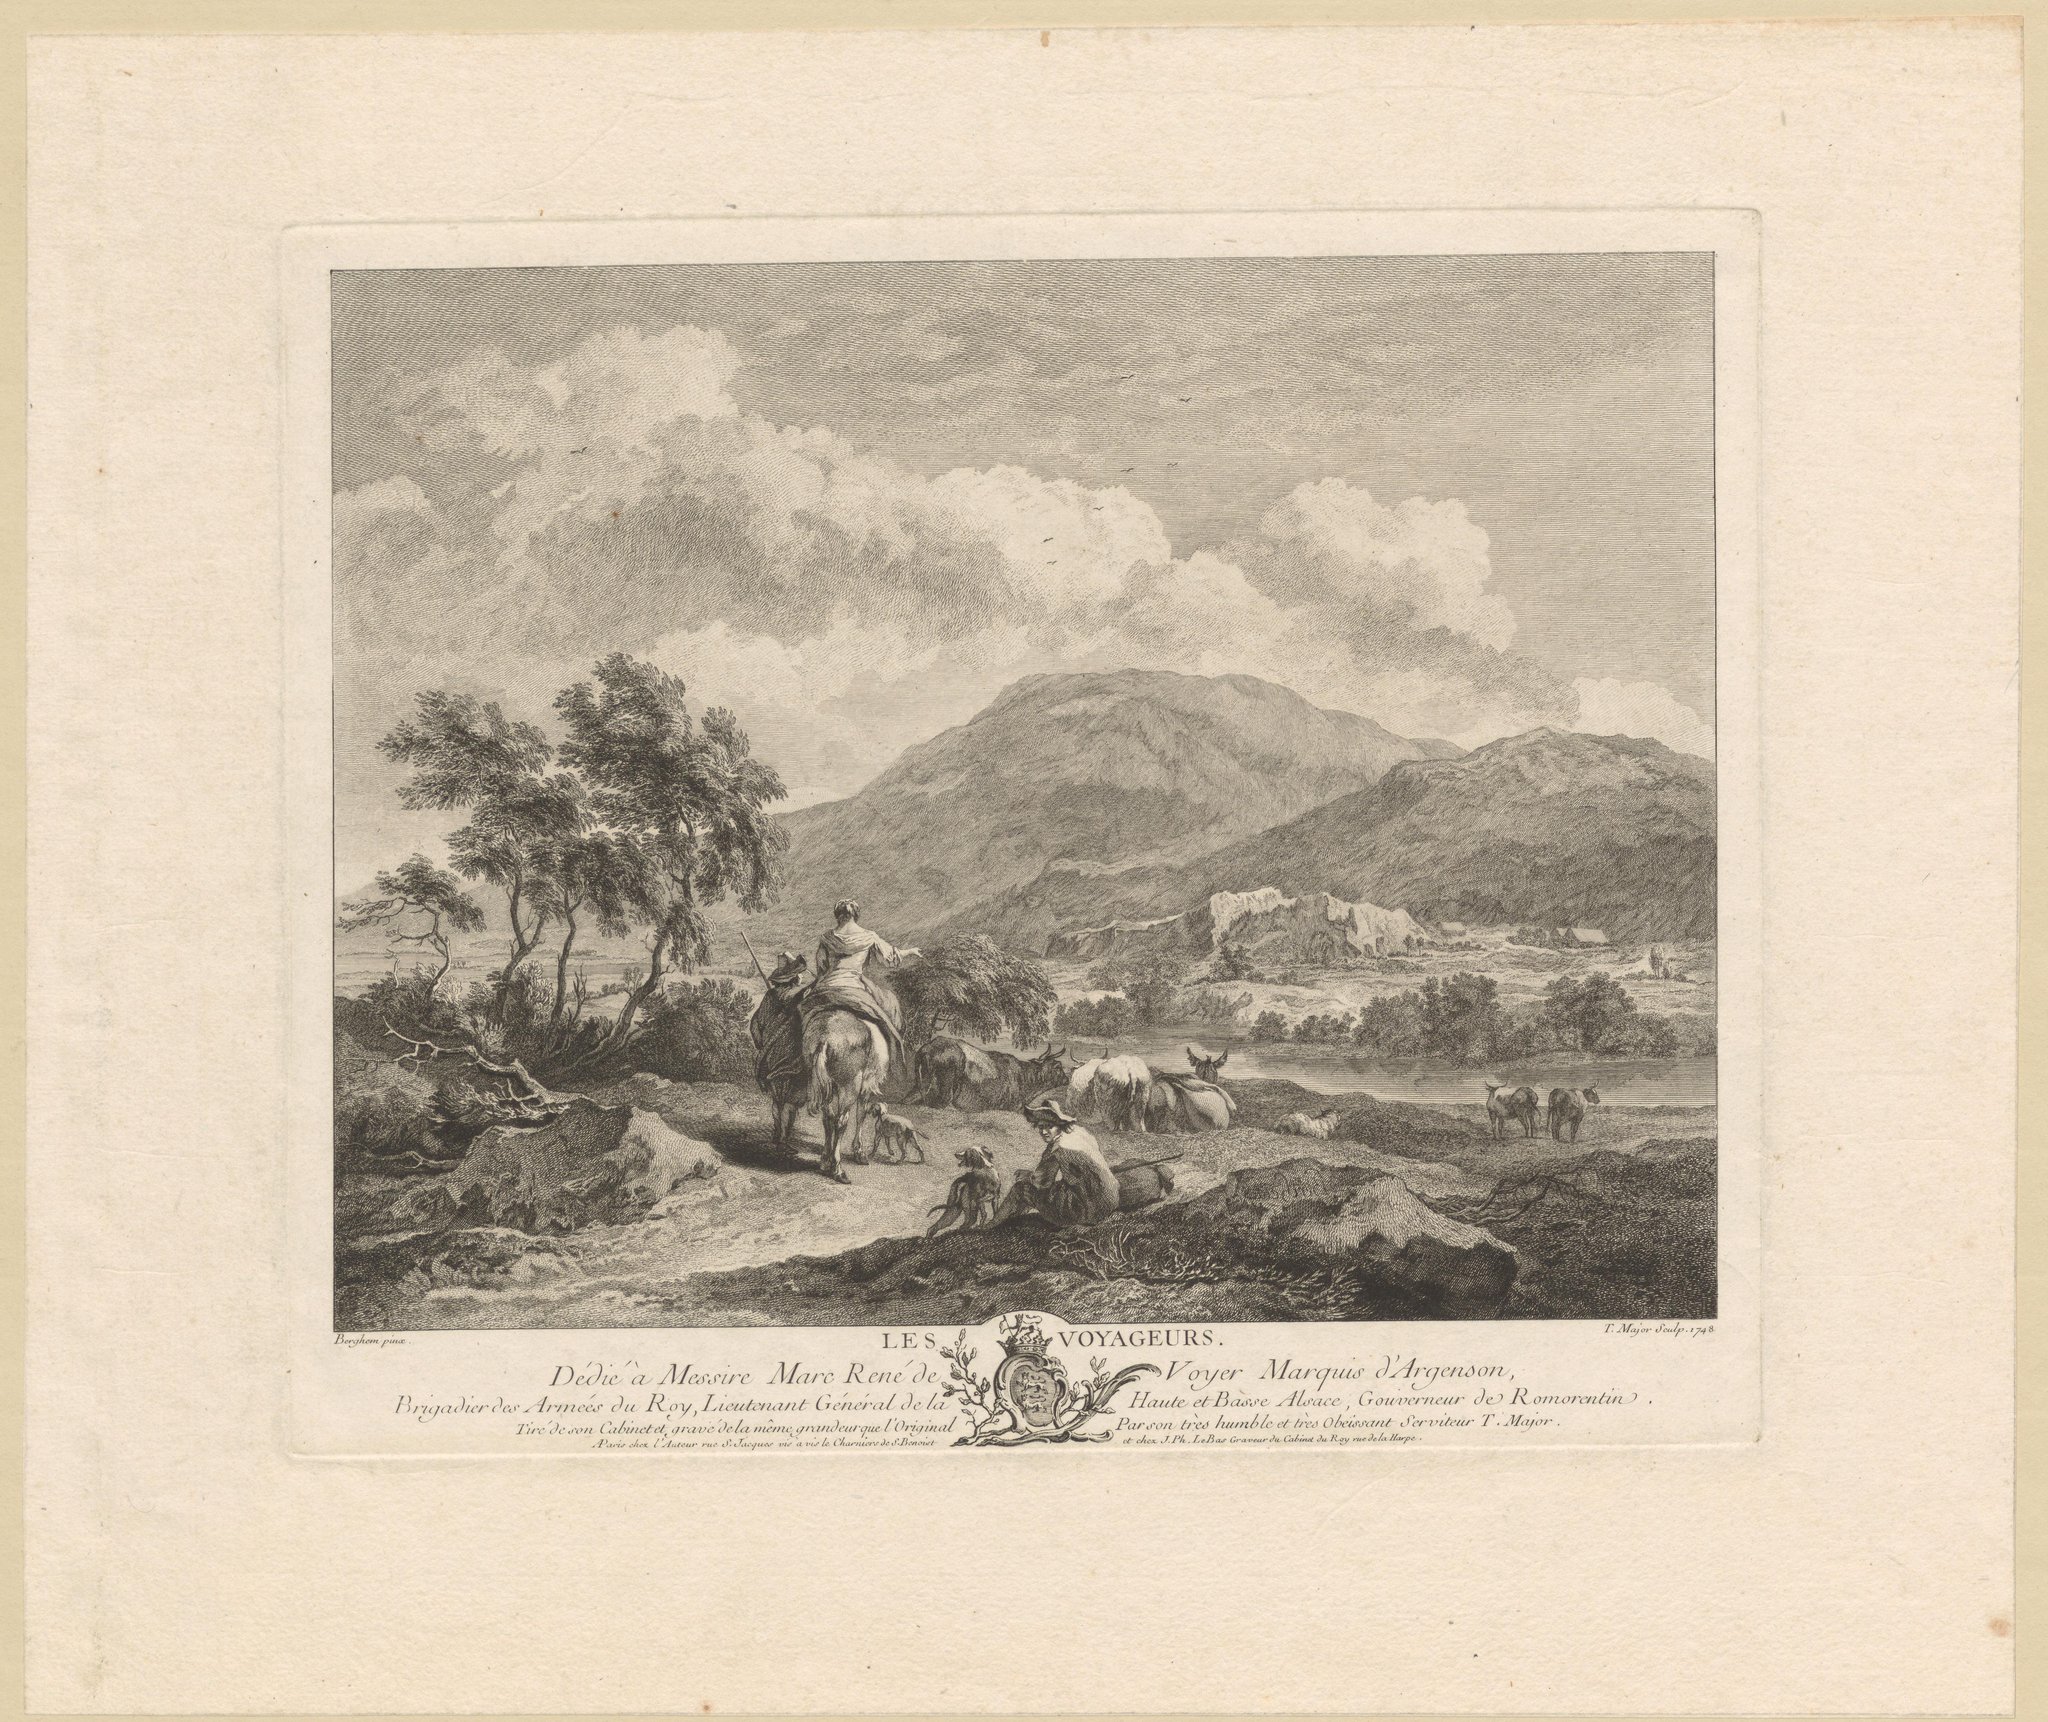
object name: print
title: Les Voyageurs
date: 1748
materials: paper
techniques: etching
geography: paris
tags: herding, herdsman, herdswoman, shepherd, shepherdess, cowherd, etc., (traveller) resting in the open air, low hill country (+ landscape with figures, staffage)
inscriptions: collector's mark: Lugt 240